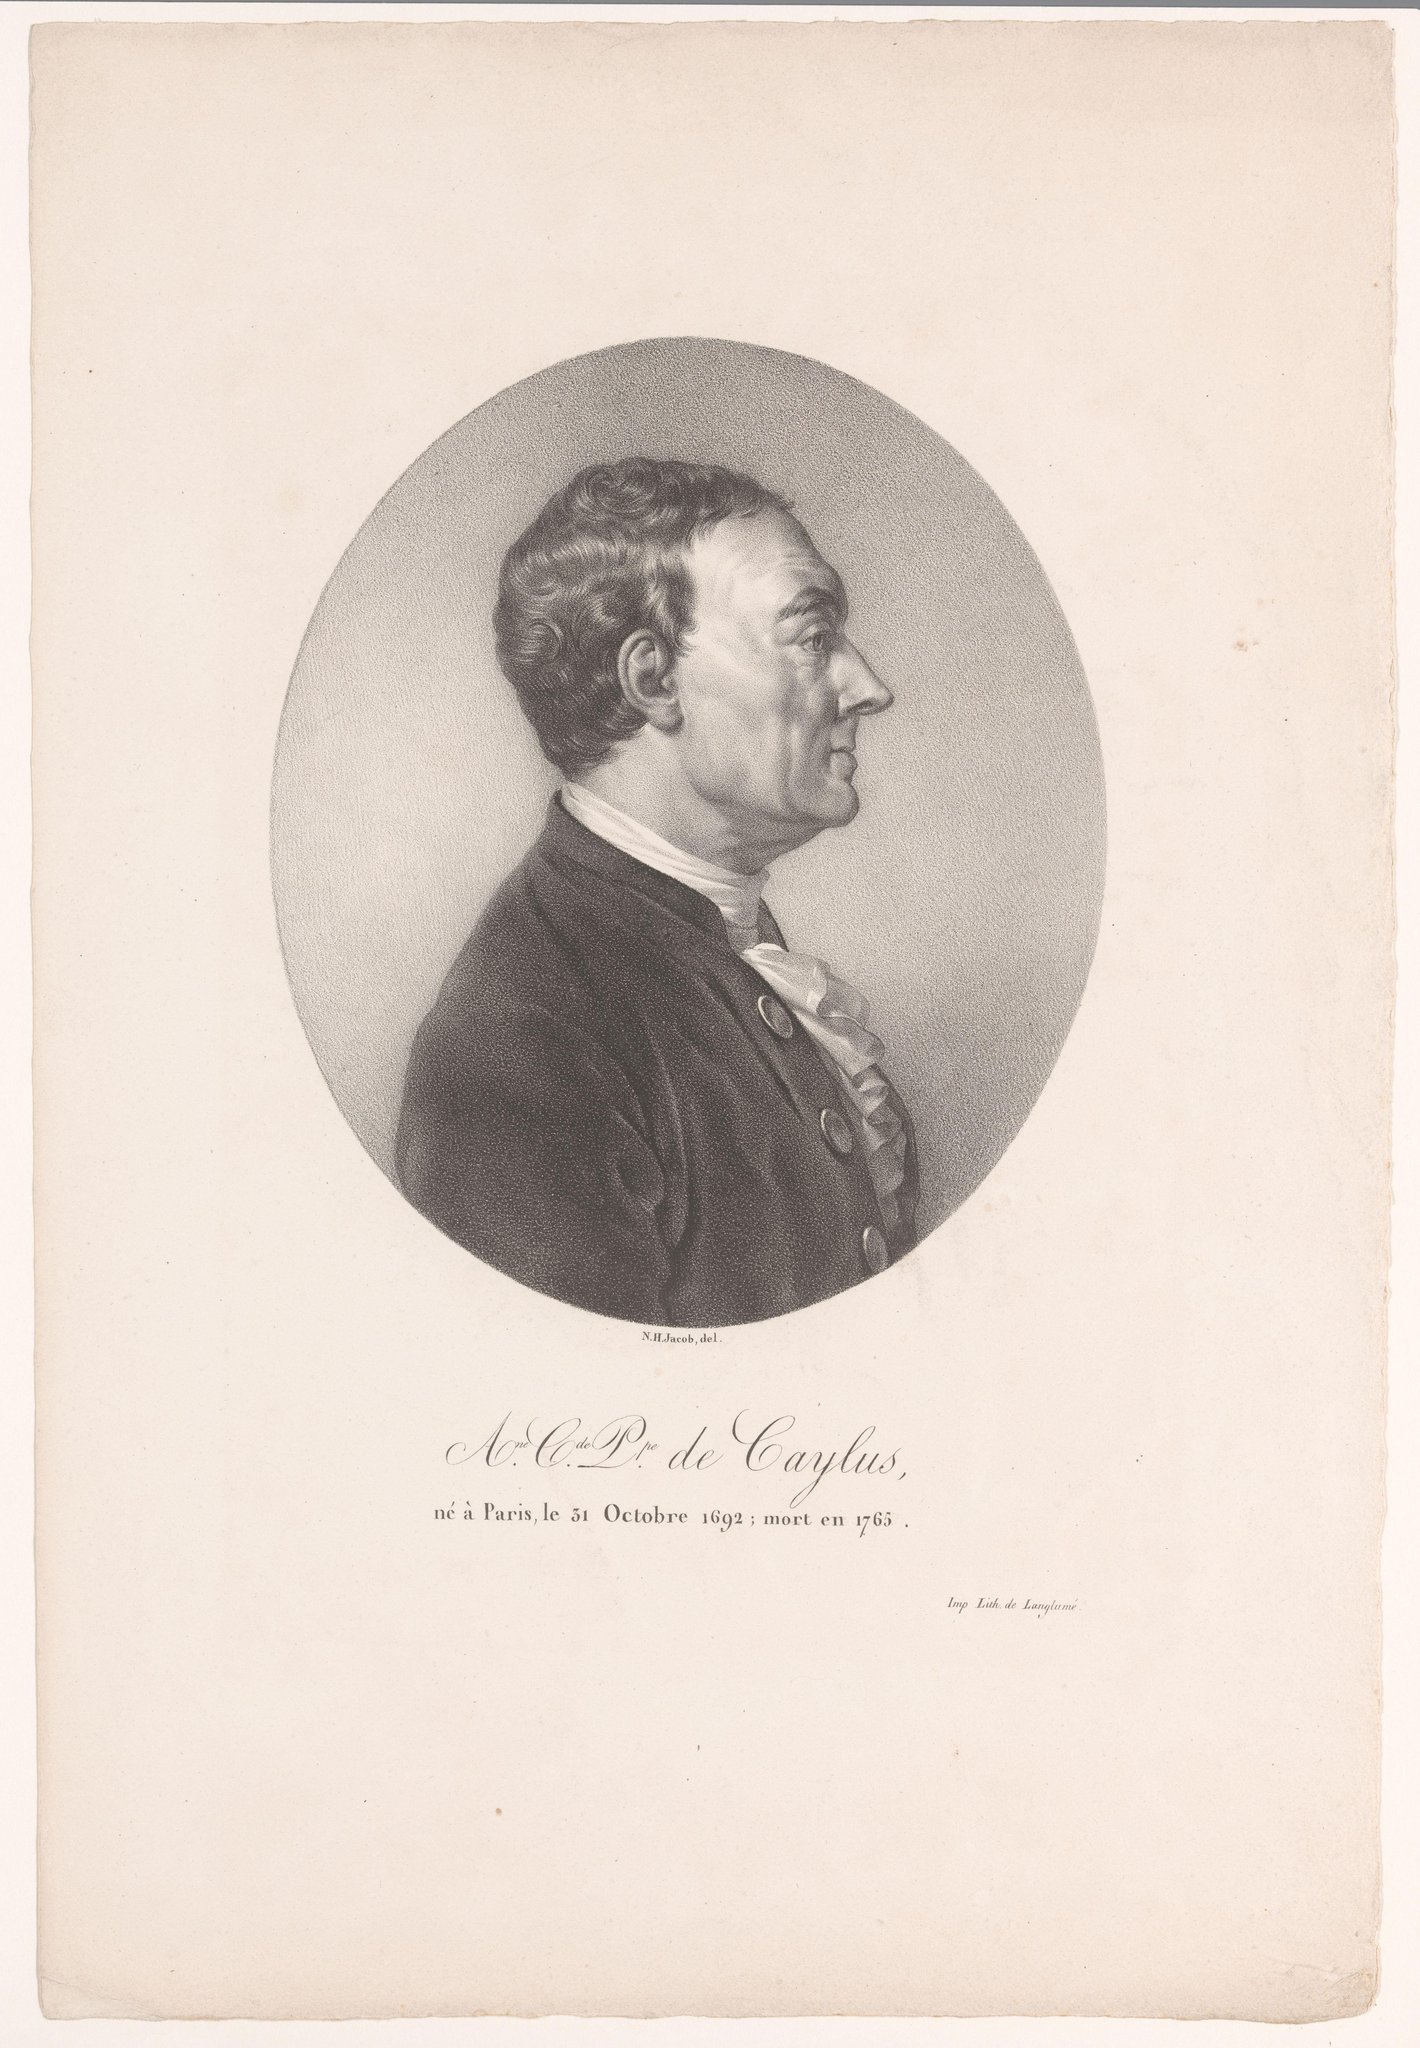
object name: print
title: Portret van Anne Claude de Caylus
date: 1825-1827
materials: paper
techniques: lithograph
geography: paris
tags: paris, print maker, anne claude philippe caylus, historical persons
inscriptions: collector's mark: Lugt 2228a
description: Prent gebruikt voor: Le Panthéon français, ou Collection de portraits des personnages célèbres (...). Parijs: P. Sudré, 1825-1827.